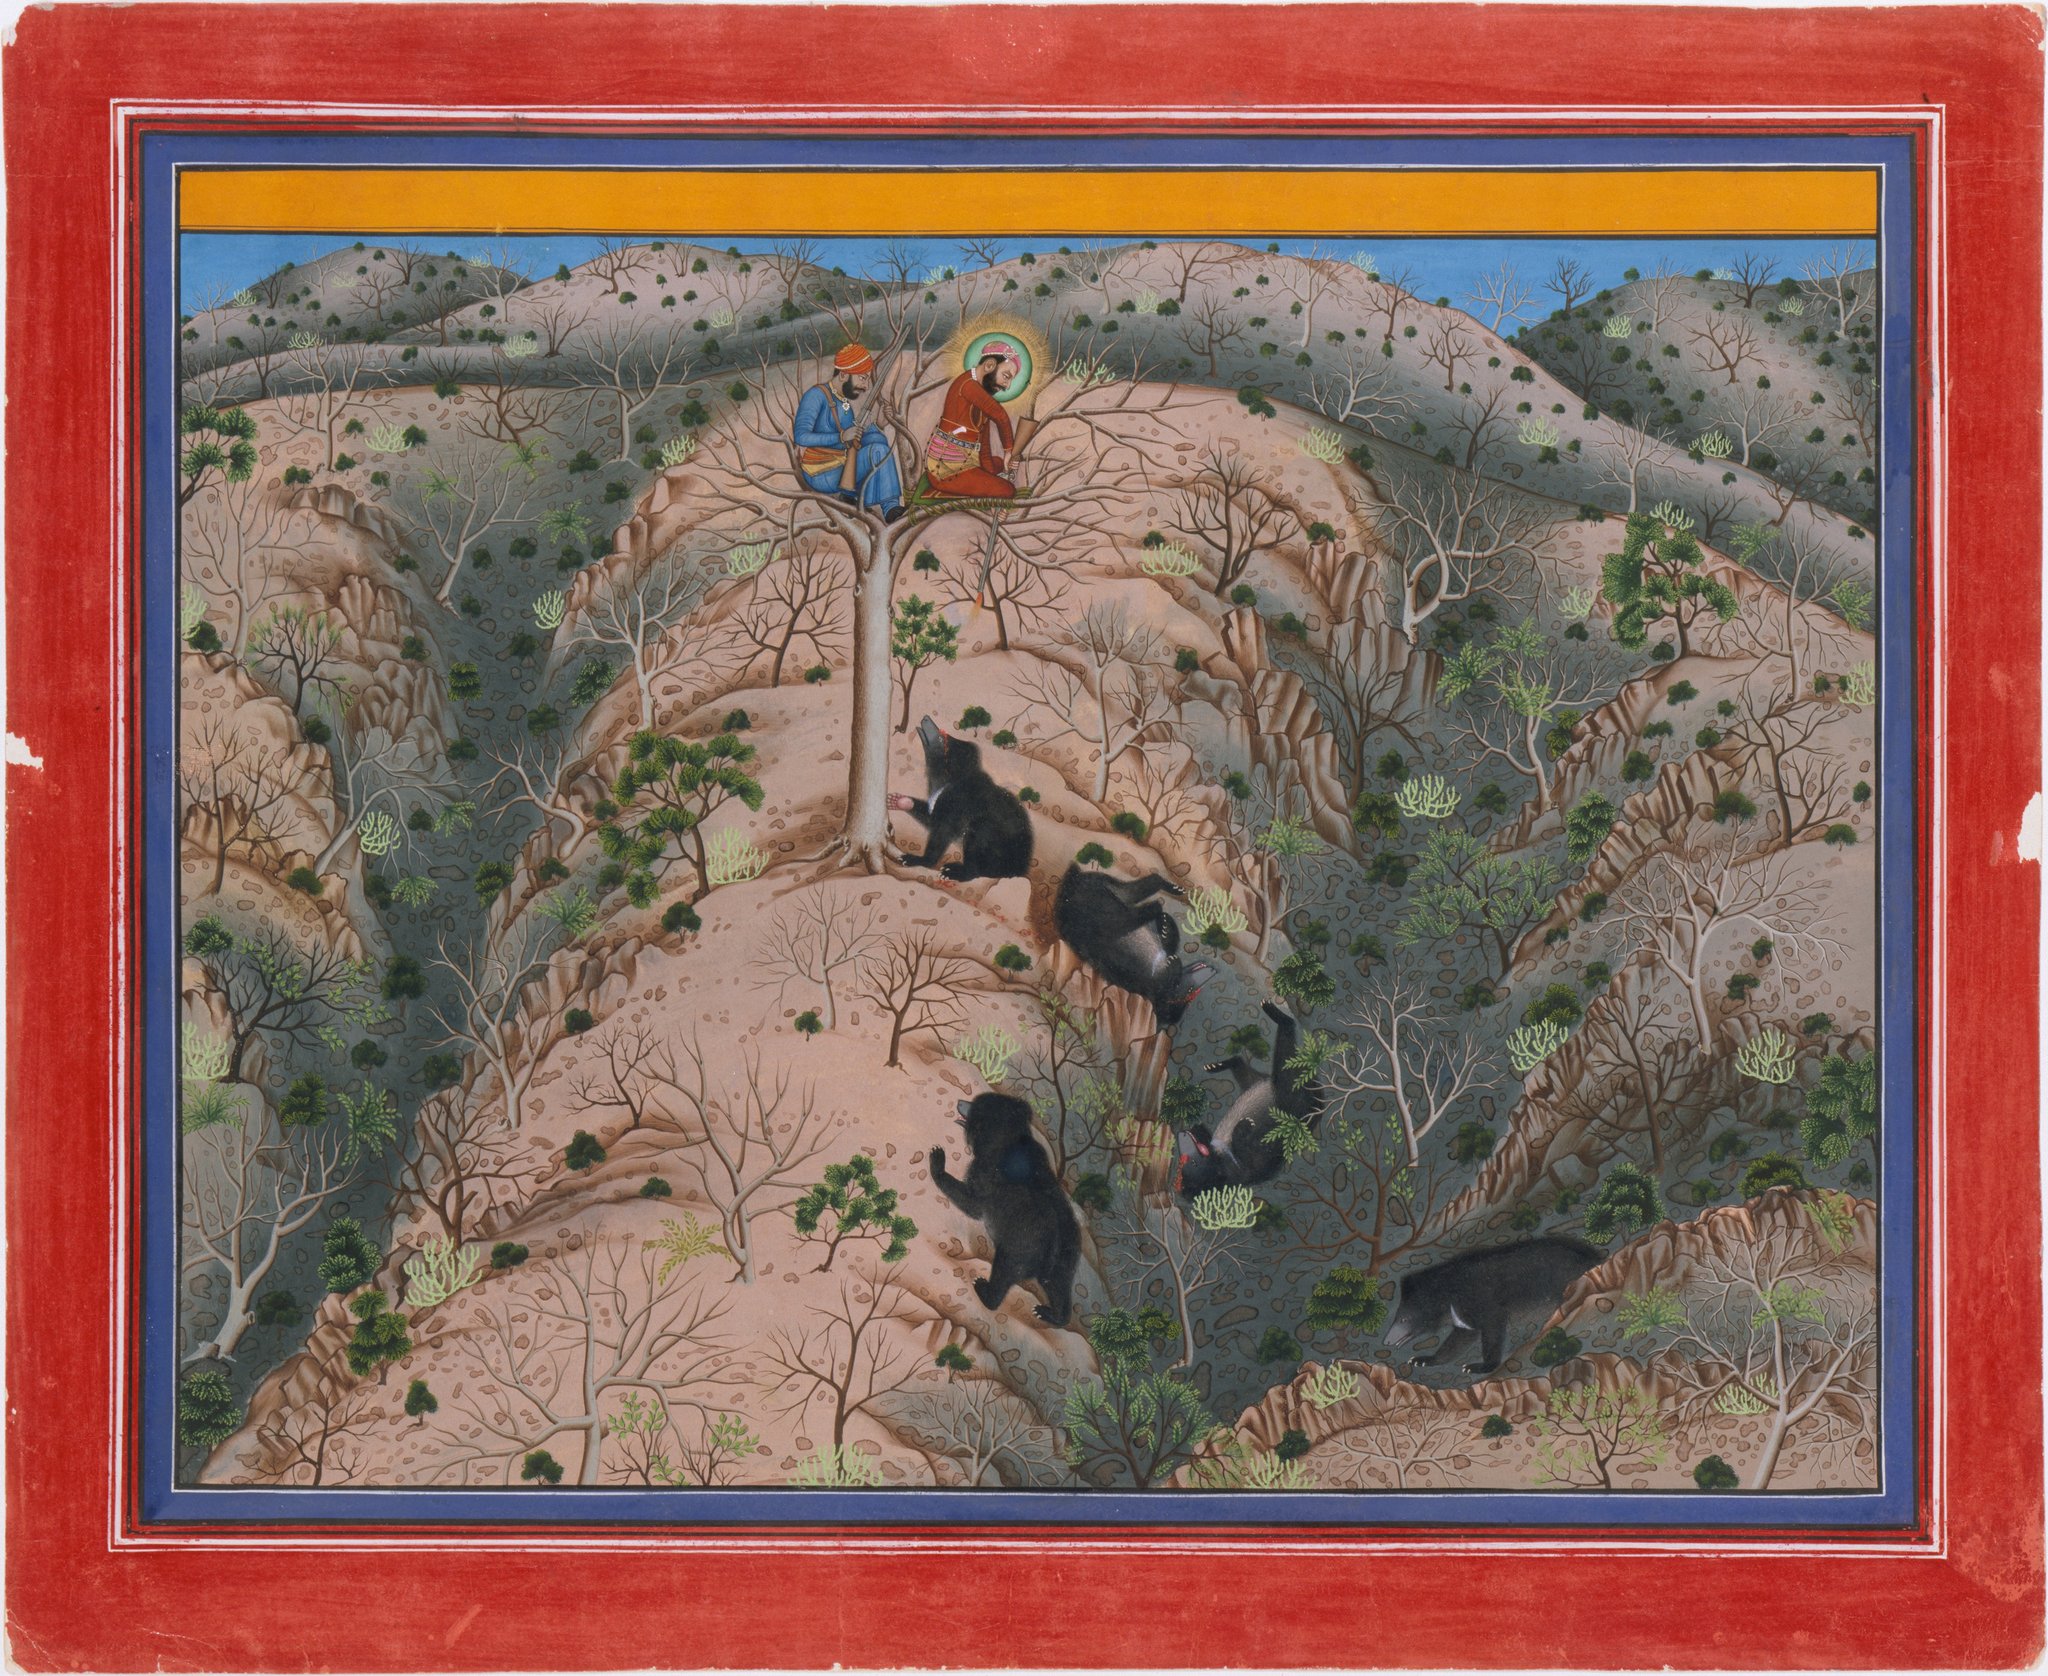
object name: painting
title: Maharaja Fateh Singh Hunting Female Bears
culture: western indian, rajasthan, udaipur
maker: pannalai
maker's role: artist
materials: gold, ink, paper, watercolor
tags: bears,men,hunting